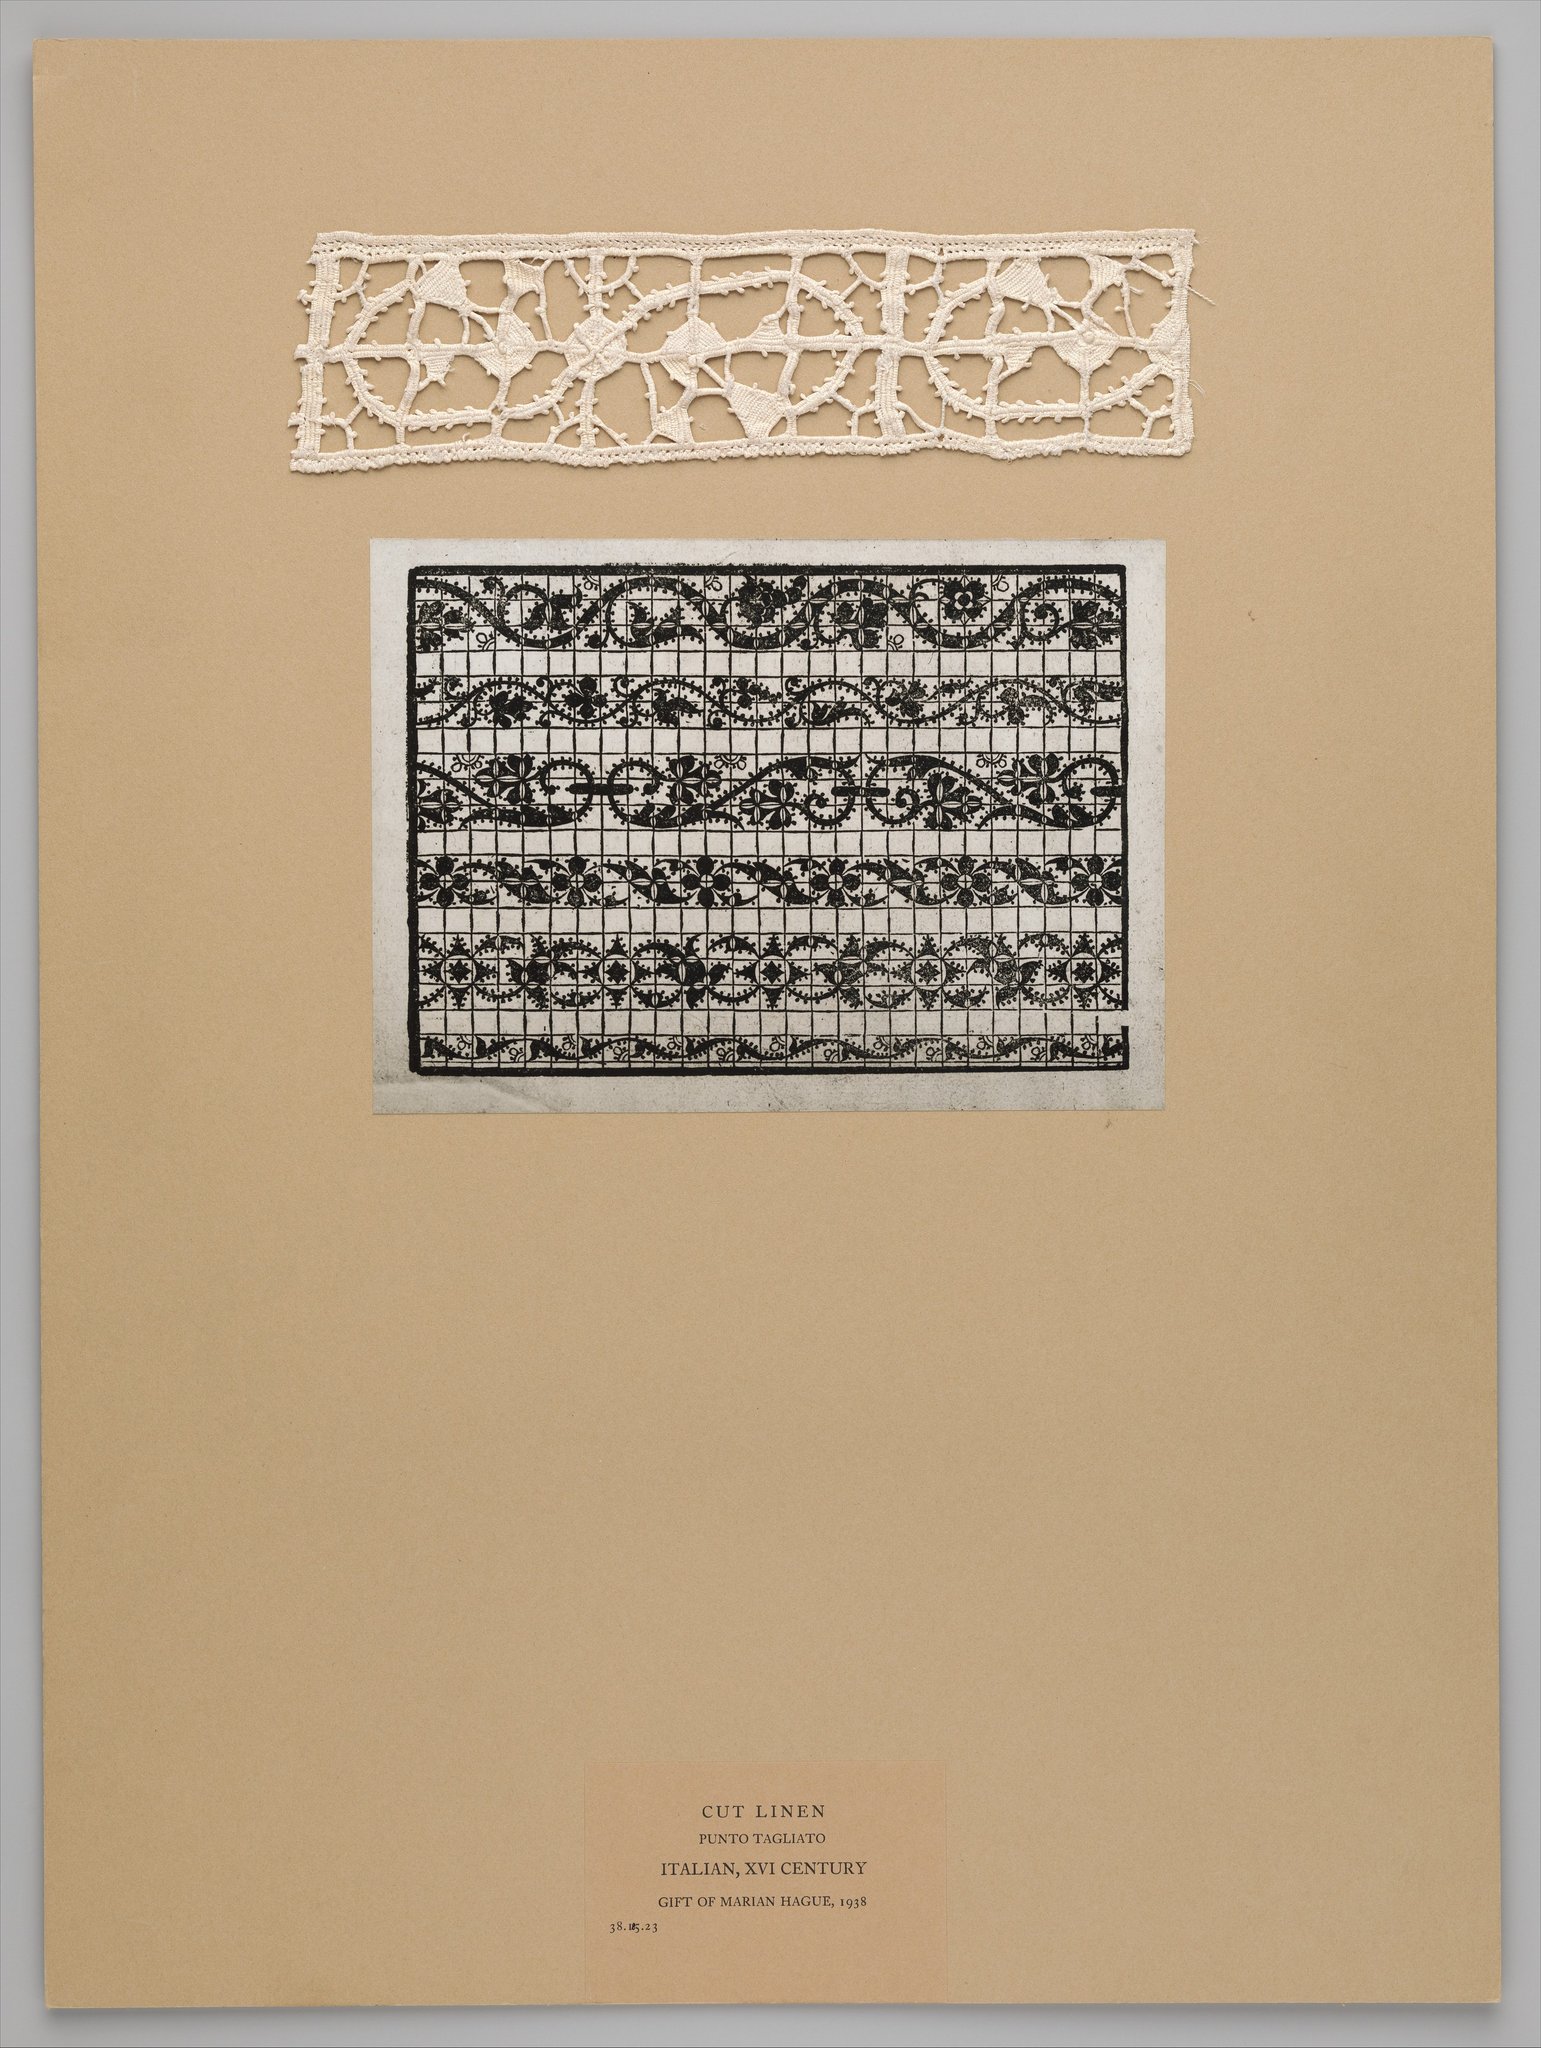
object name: insertion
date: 1501-1600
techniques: embroidery